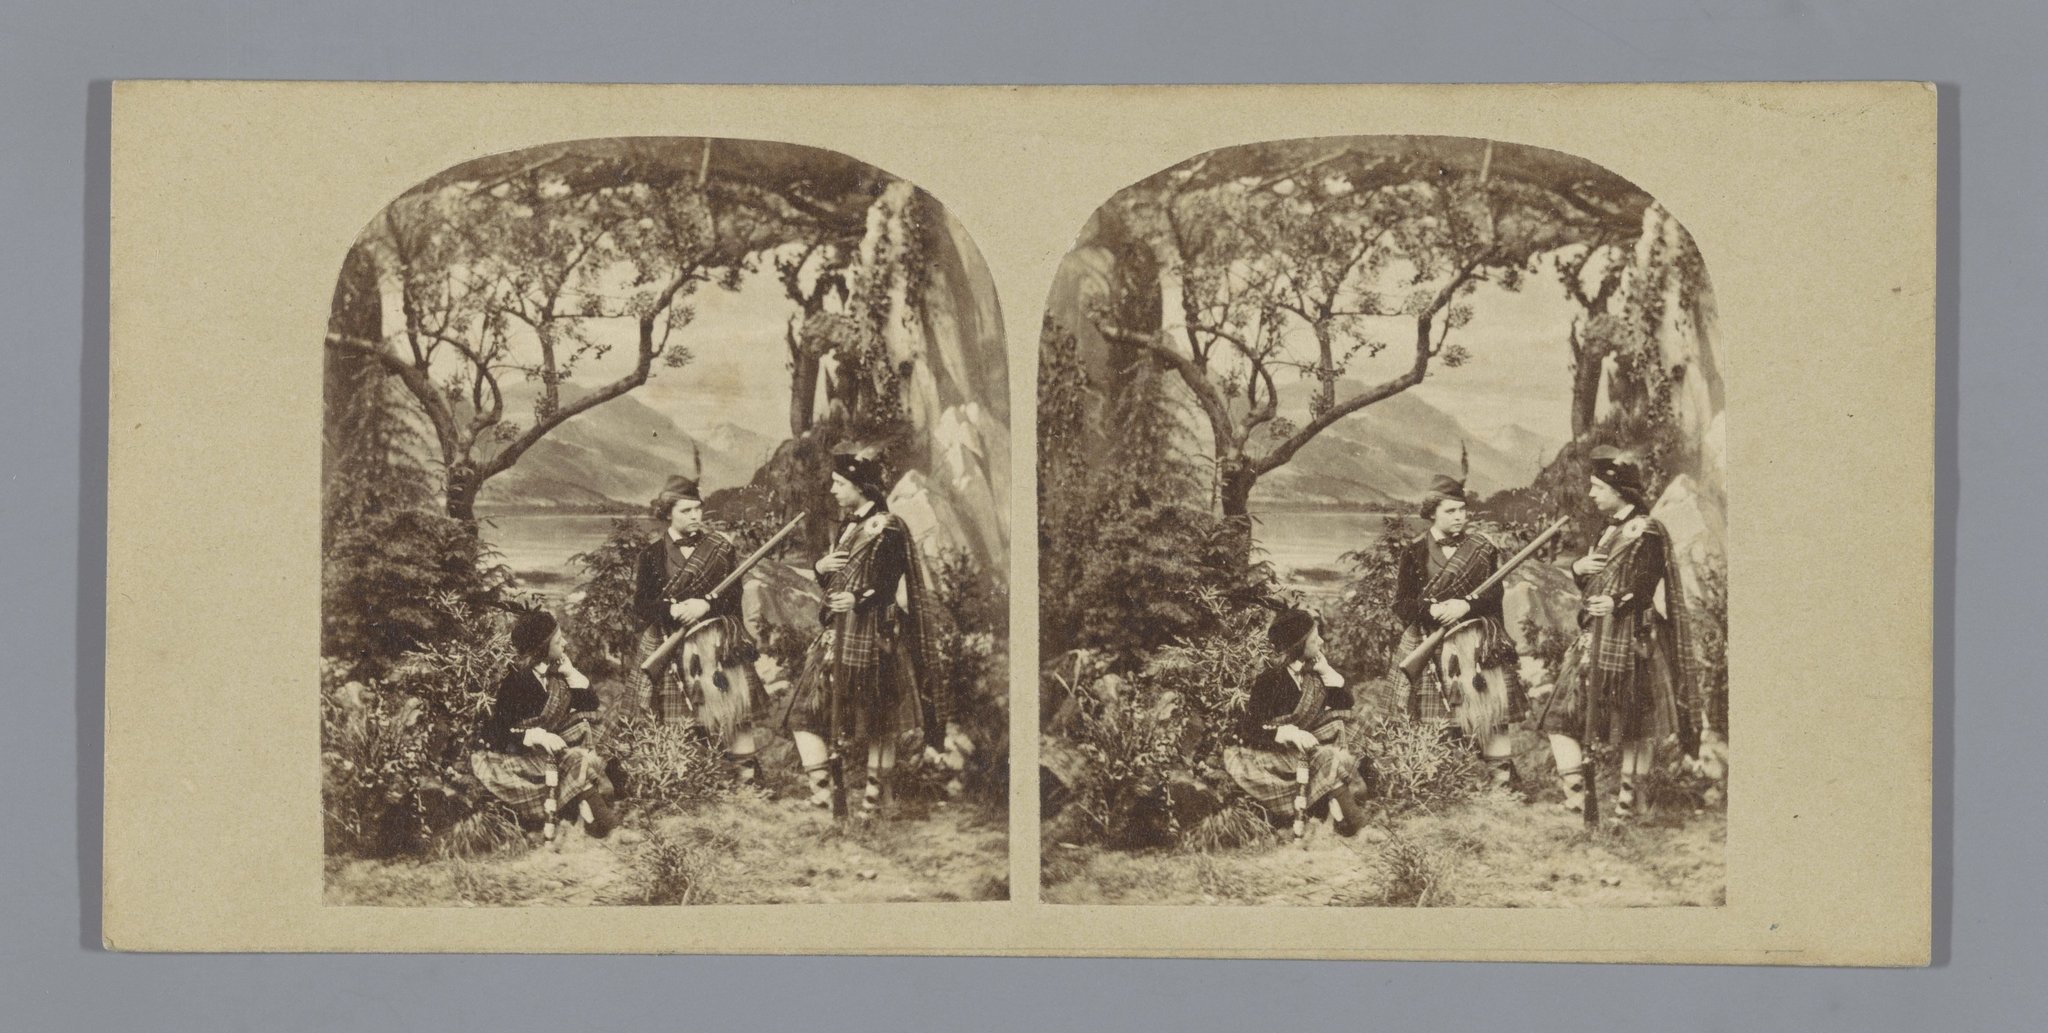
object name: stereograph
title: Drie doedelzakspelers voor een decor met bomen en bergen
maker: Anonymous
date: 1850-1880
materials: cardboard, photographic support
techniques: albumen print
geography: europe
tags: bagpipe, musette - cc - out of doors, europe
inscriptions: number: ‘14.’